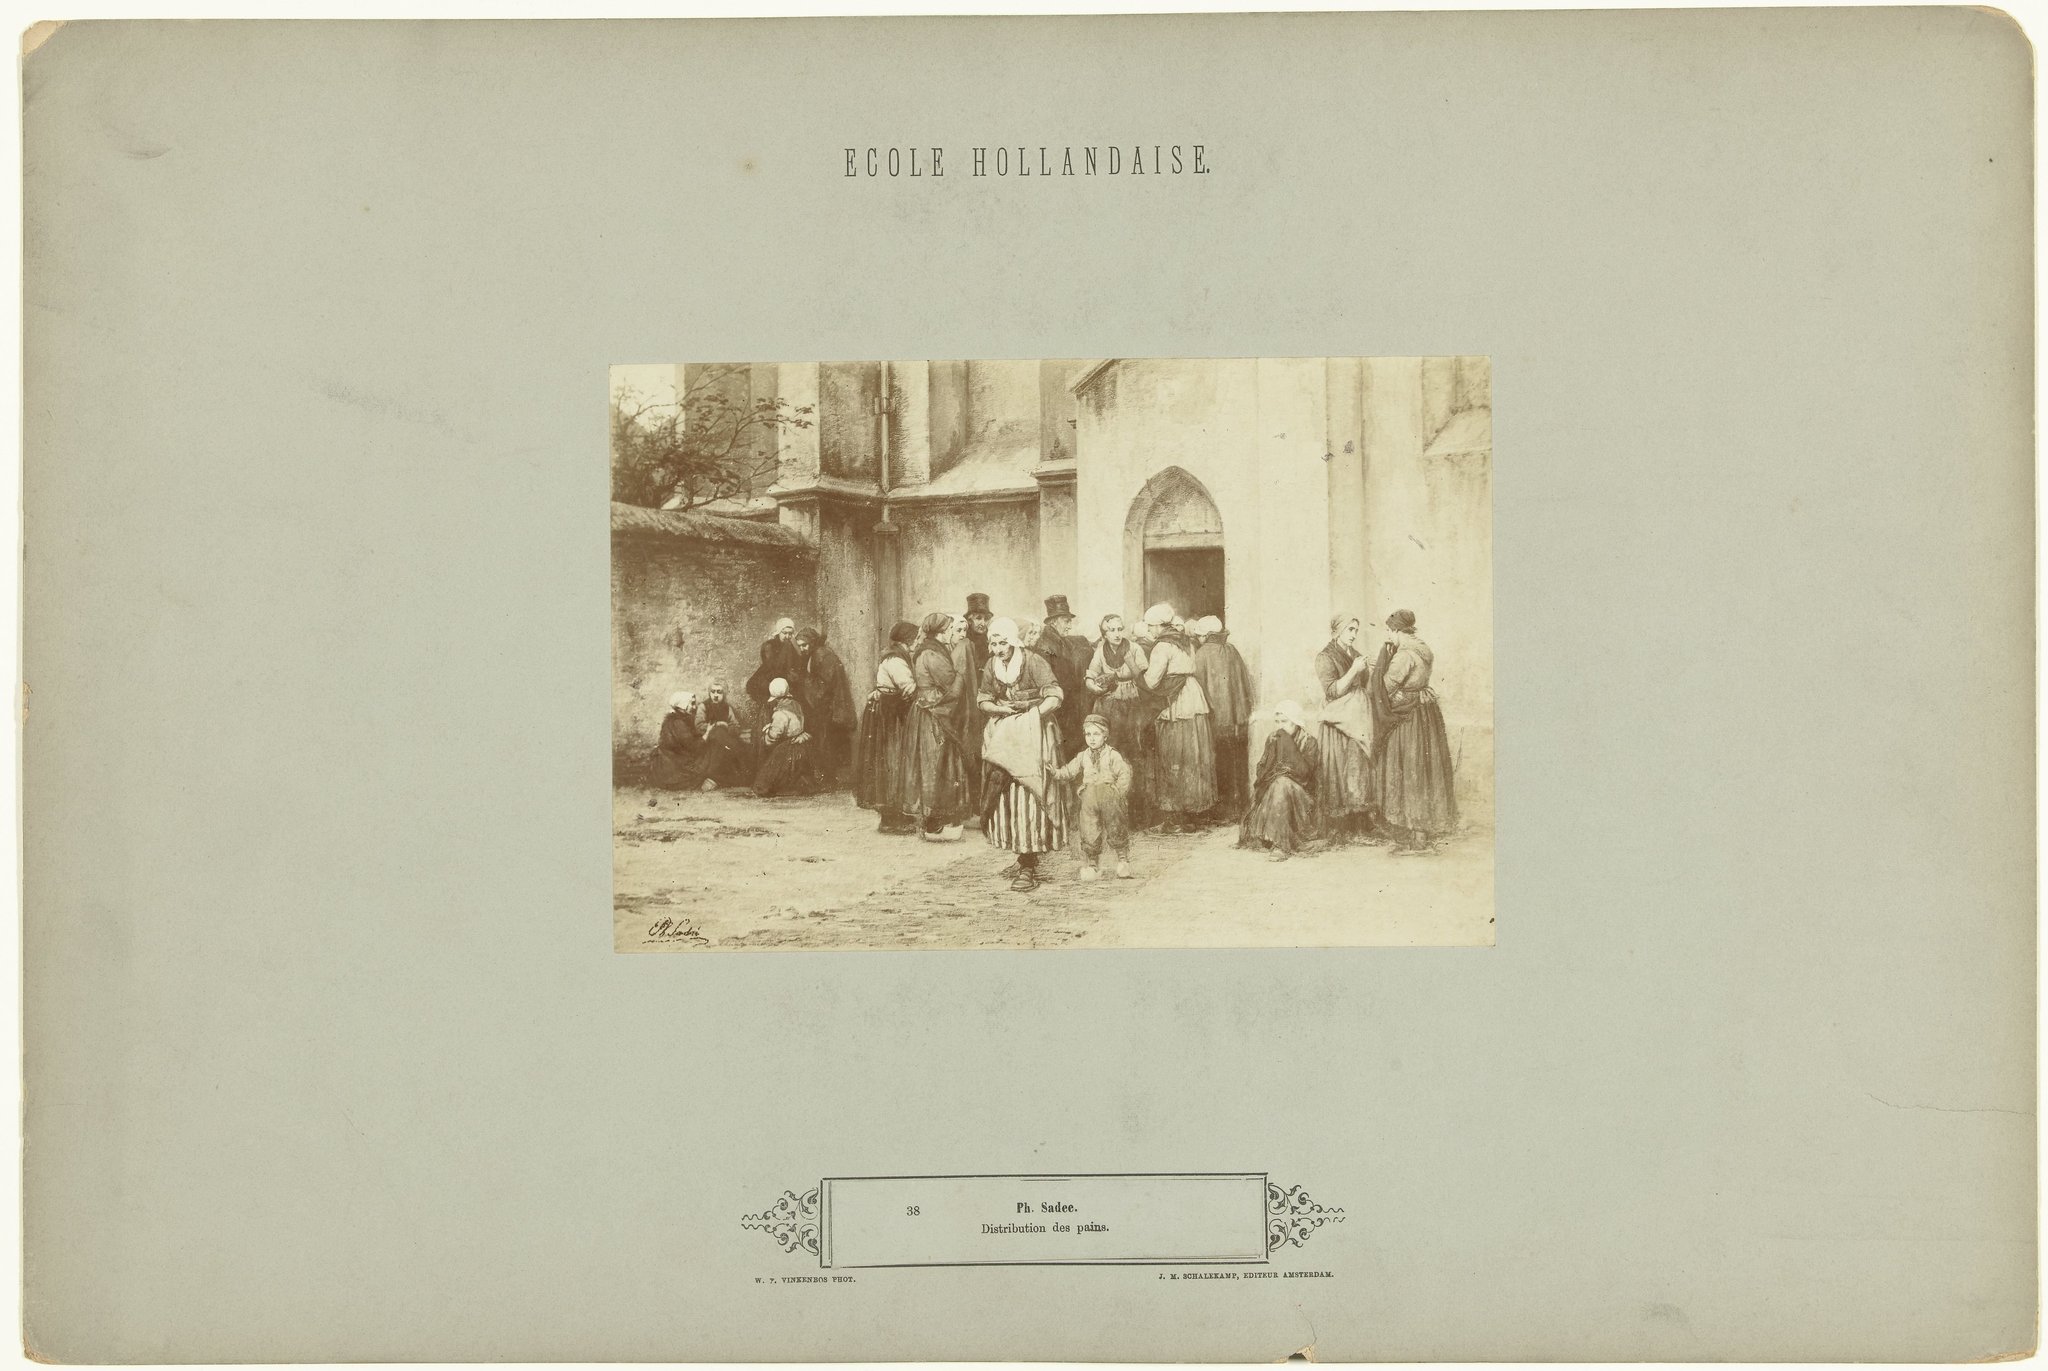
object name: photograph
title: Reproductie van tekening 'Distribution des pains' van Philip Sadée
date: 1890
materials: cardboard, photographic support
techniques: albumen print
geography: amsterdam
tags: giving alms or other charity, e.g.: handing out food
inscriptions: caption: ‘38 Ph.Sadee.//Distrubution des pains.’, caption: ‘J.M. Schalekamp, editeur Amsterdam.’, inscription: ‘ECOLE HOLLANDAISE.’, caption: ‘W.T. Vinkenbos phot.’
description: Reproductie van tekening 'Distribution des pains' van Philip Sadée.